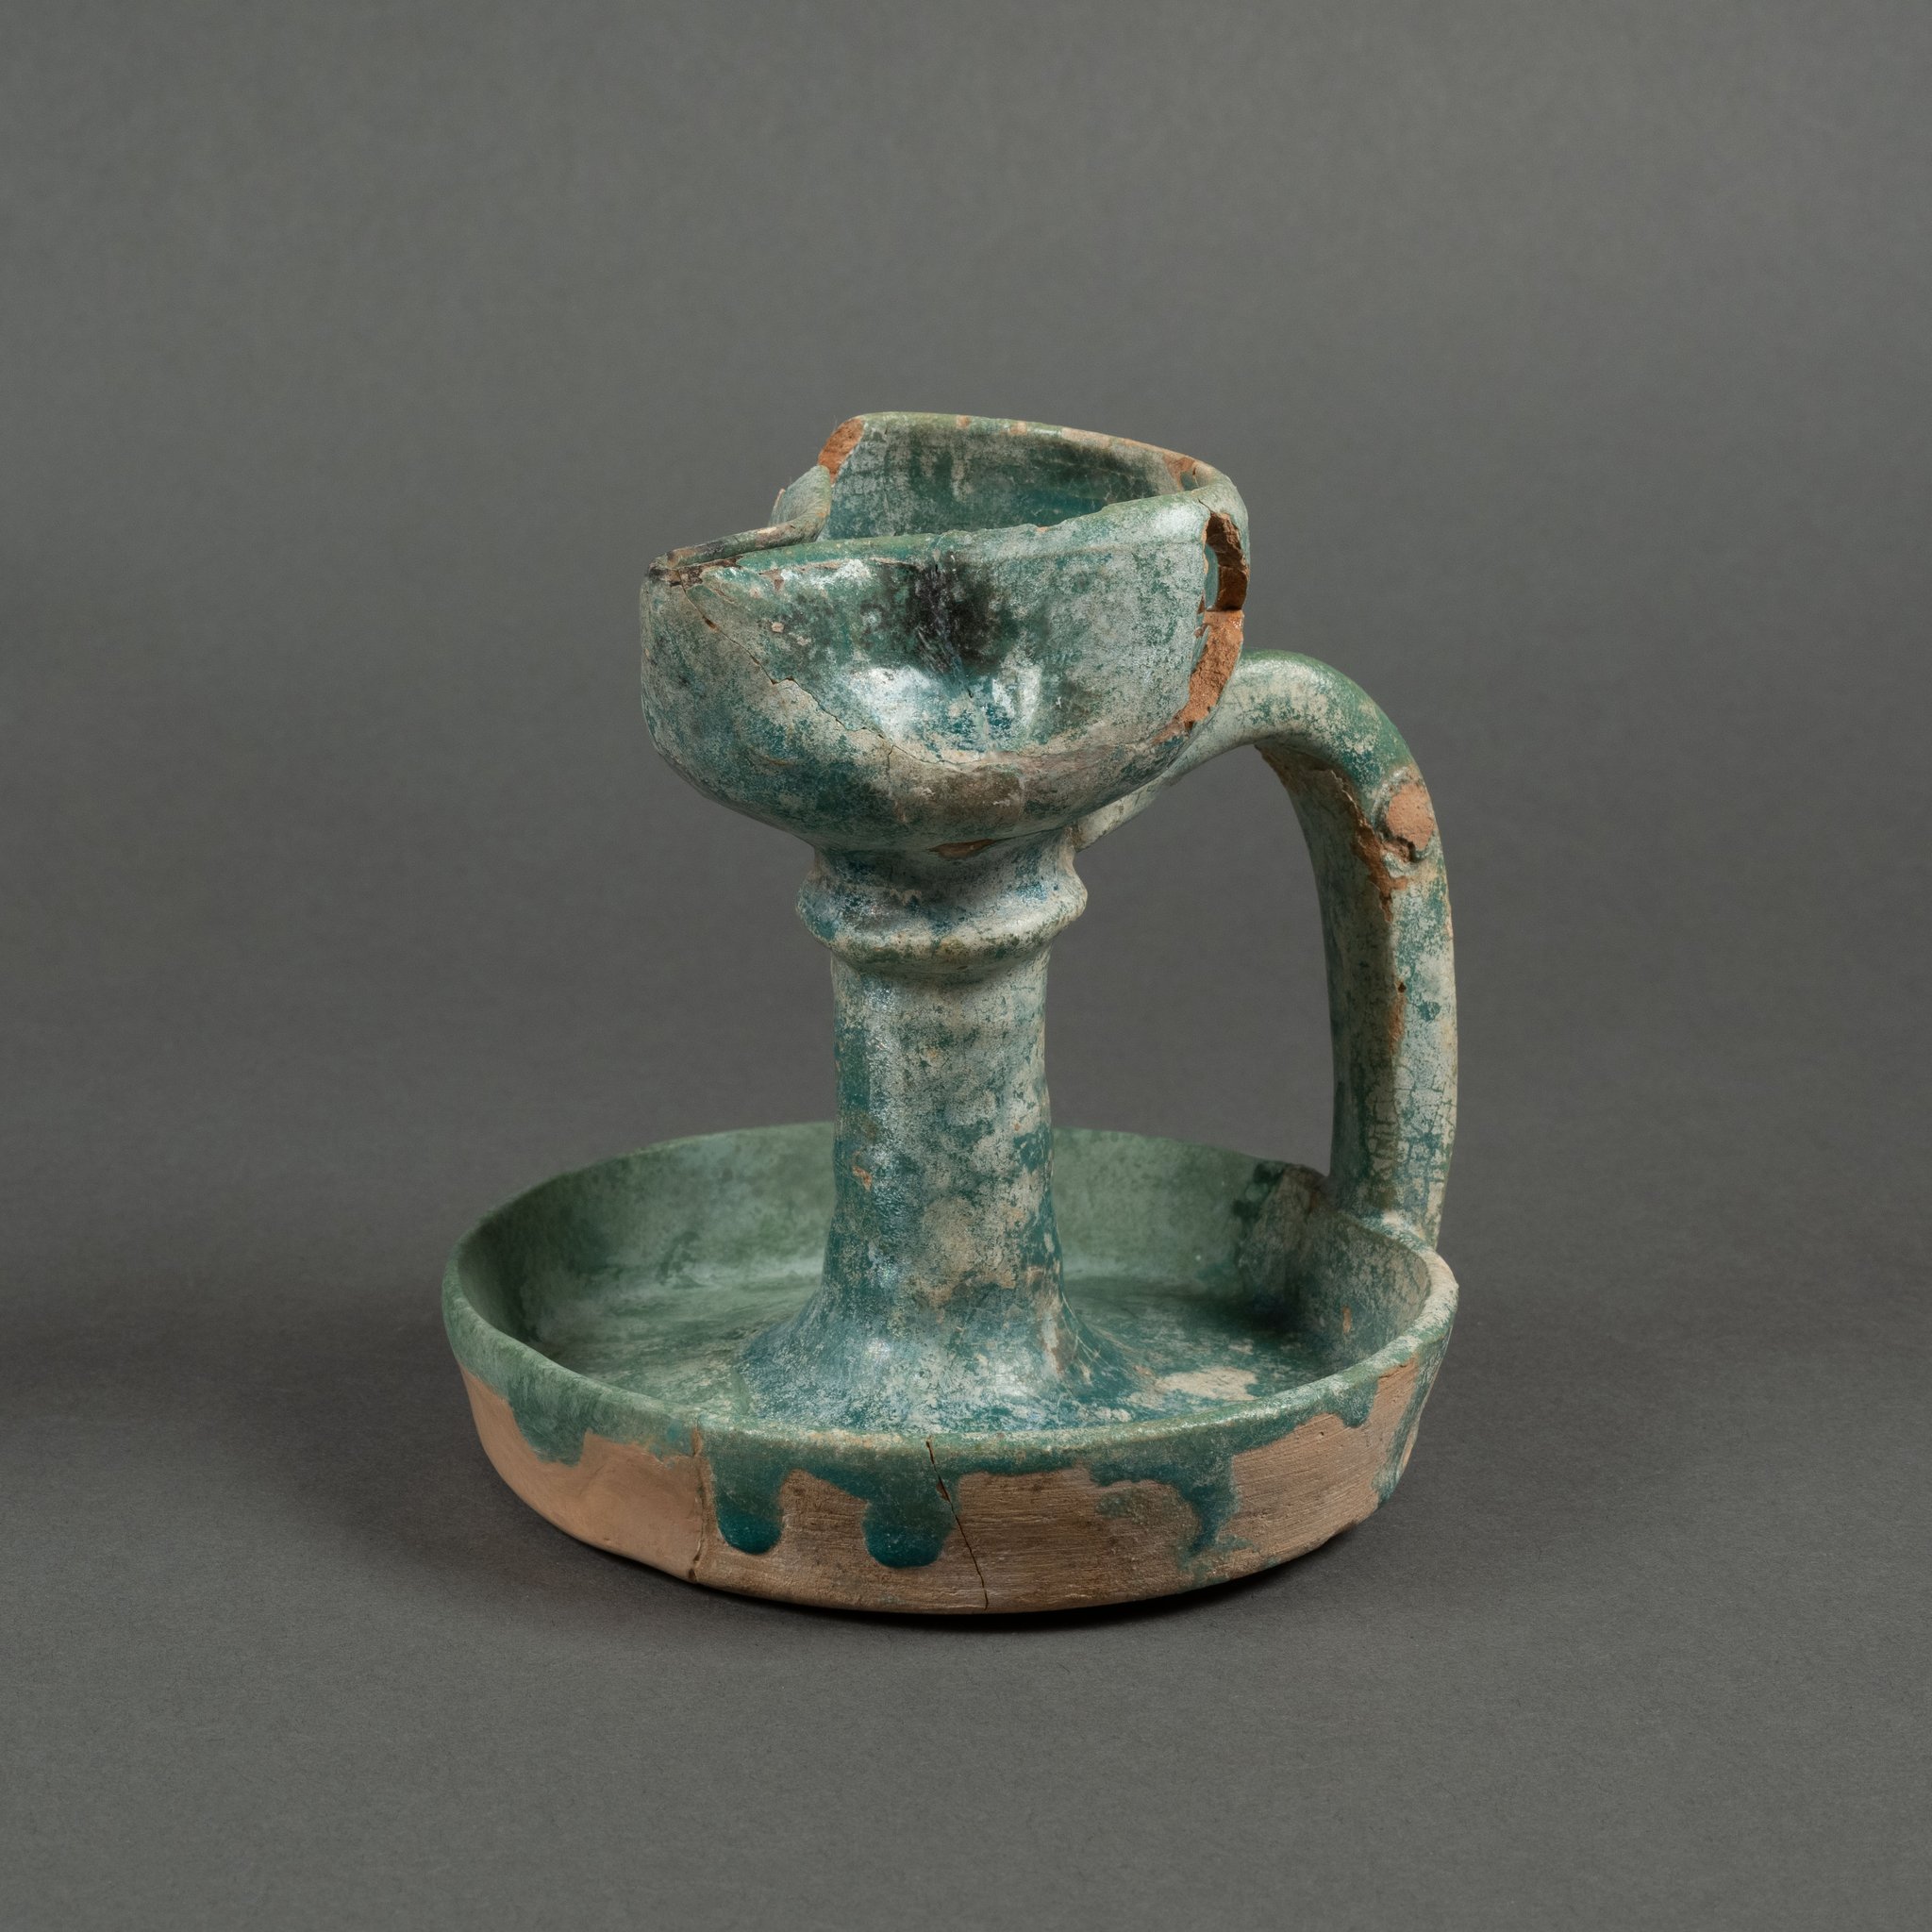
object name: lamp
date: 901-1200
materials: earthenware, glaze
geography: iran